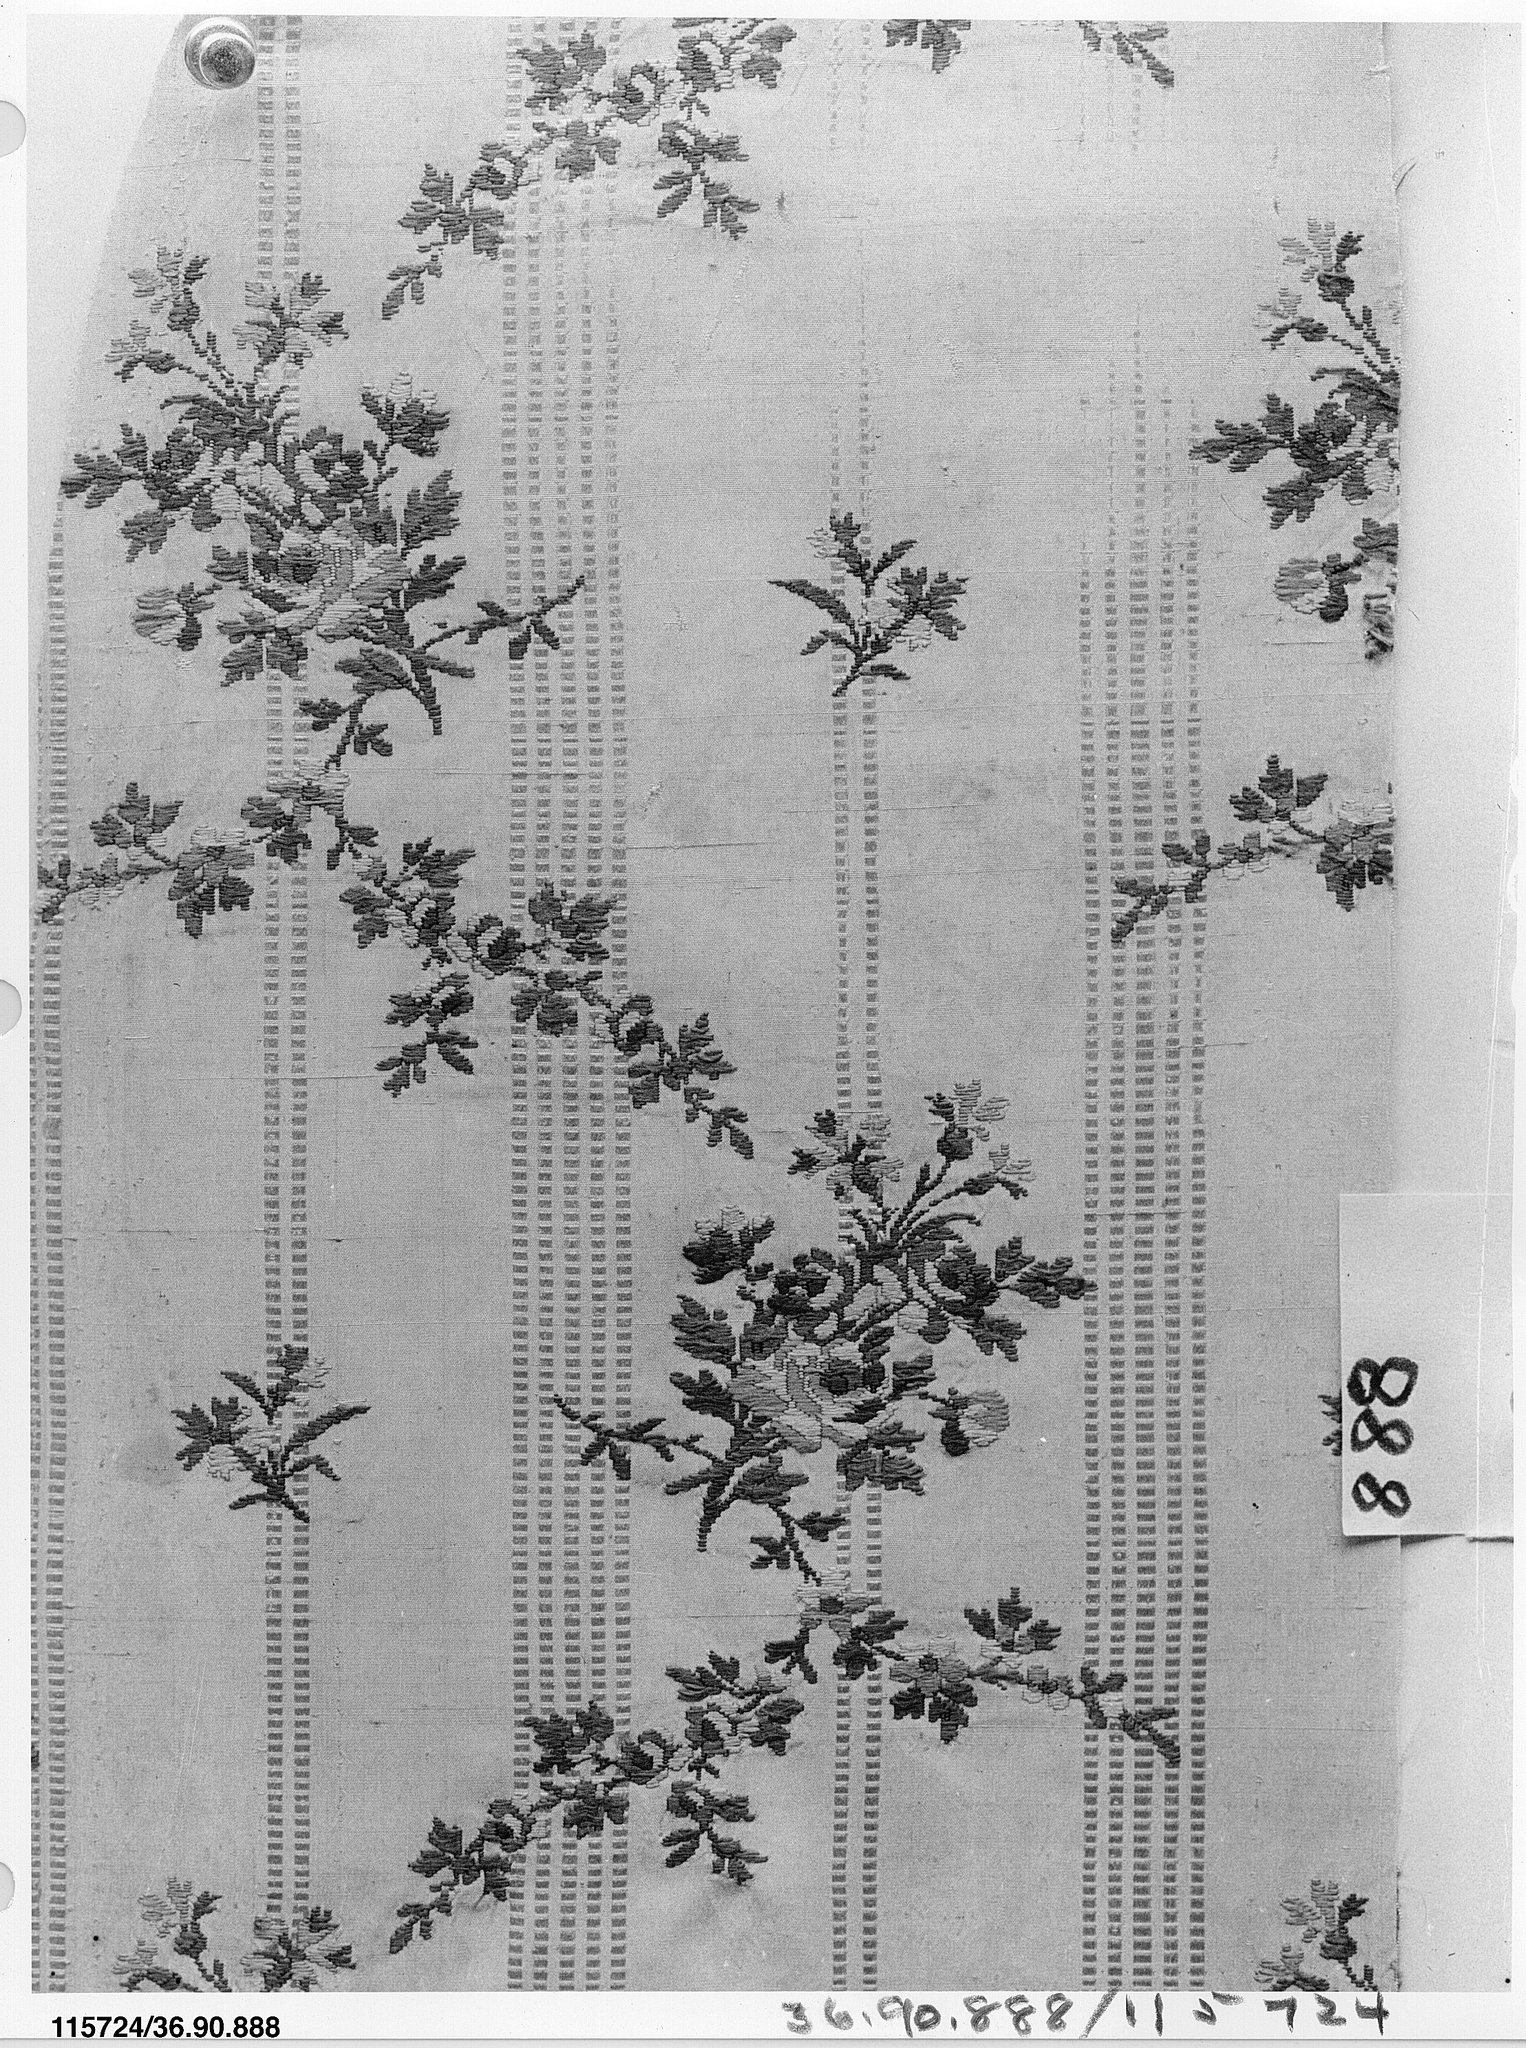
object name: piece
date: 1701-1800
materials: silk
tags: flowers,leaves